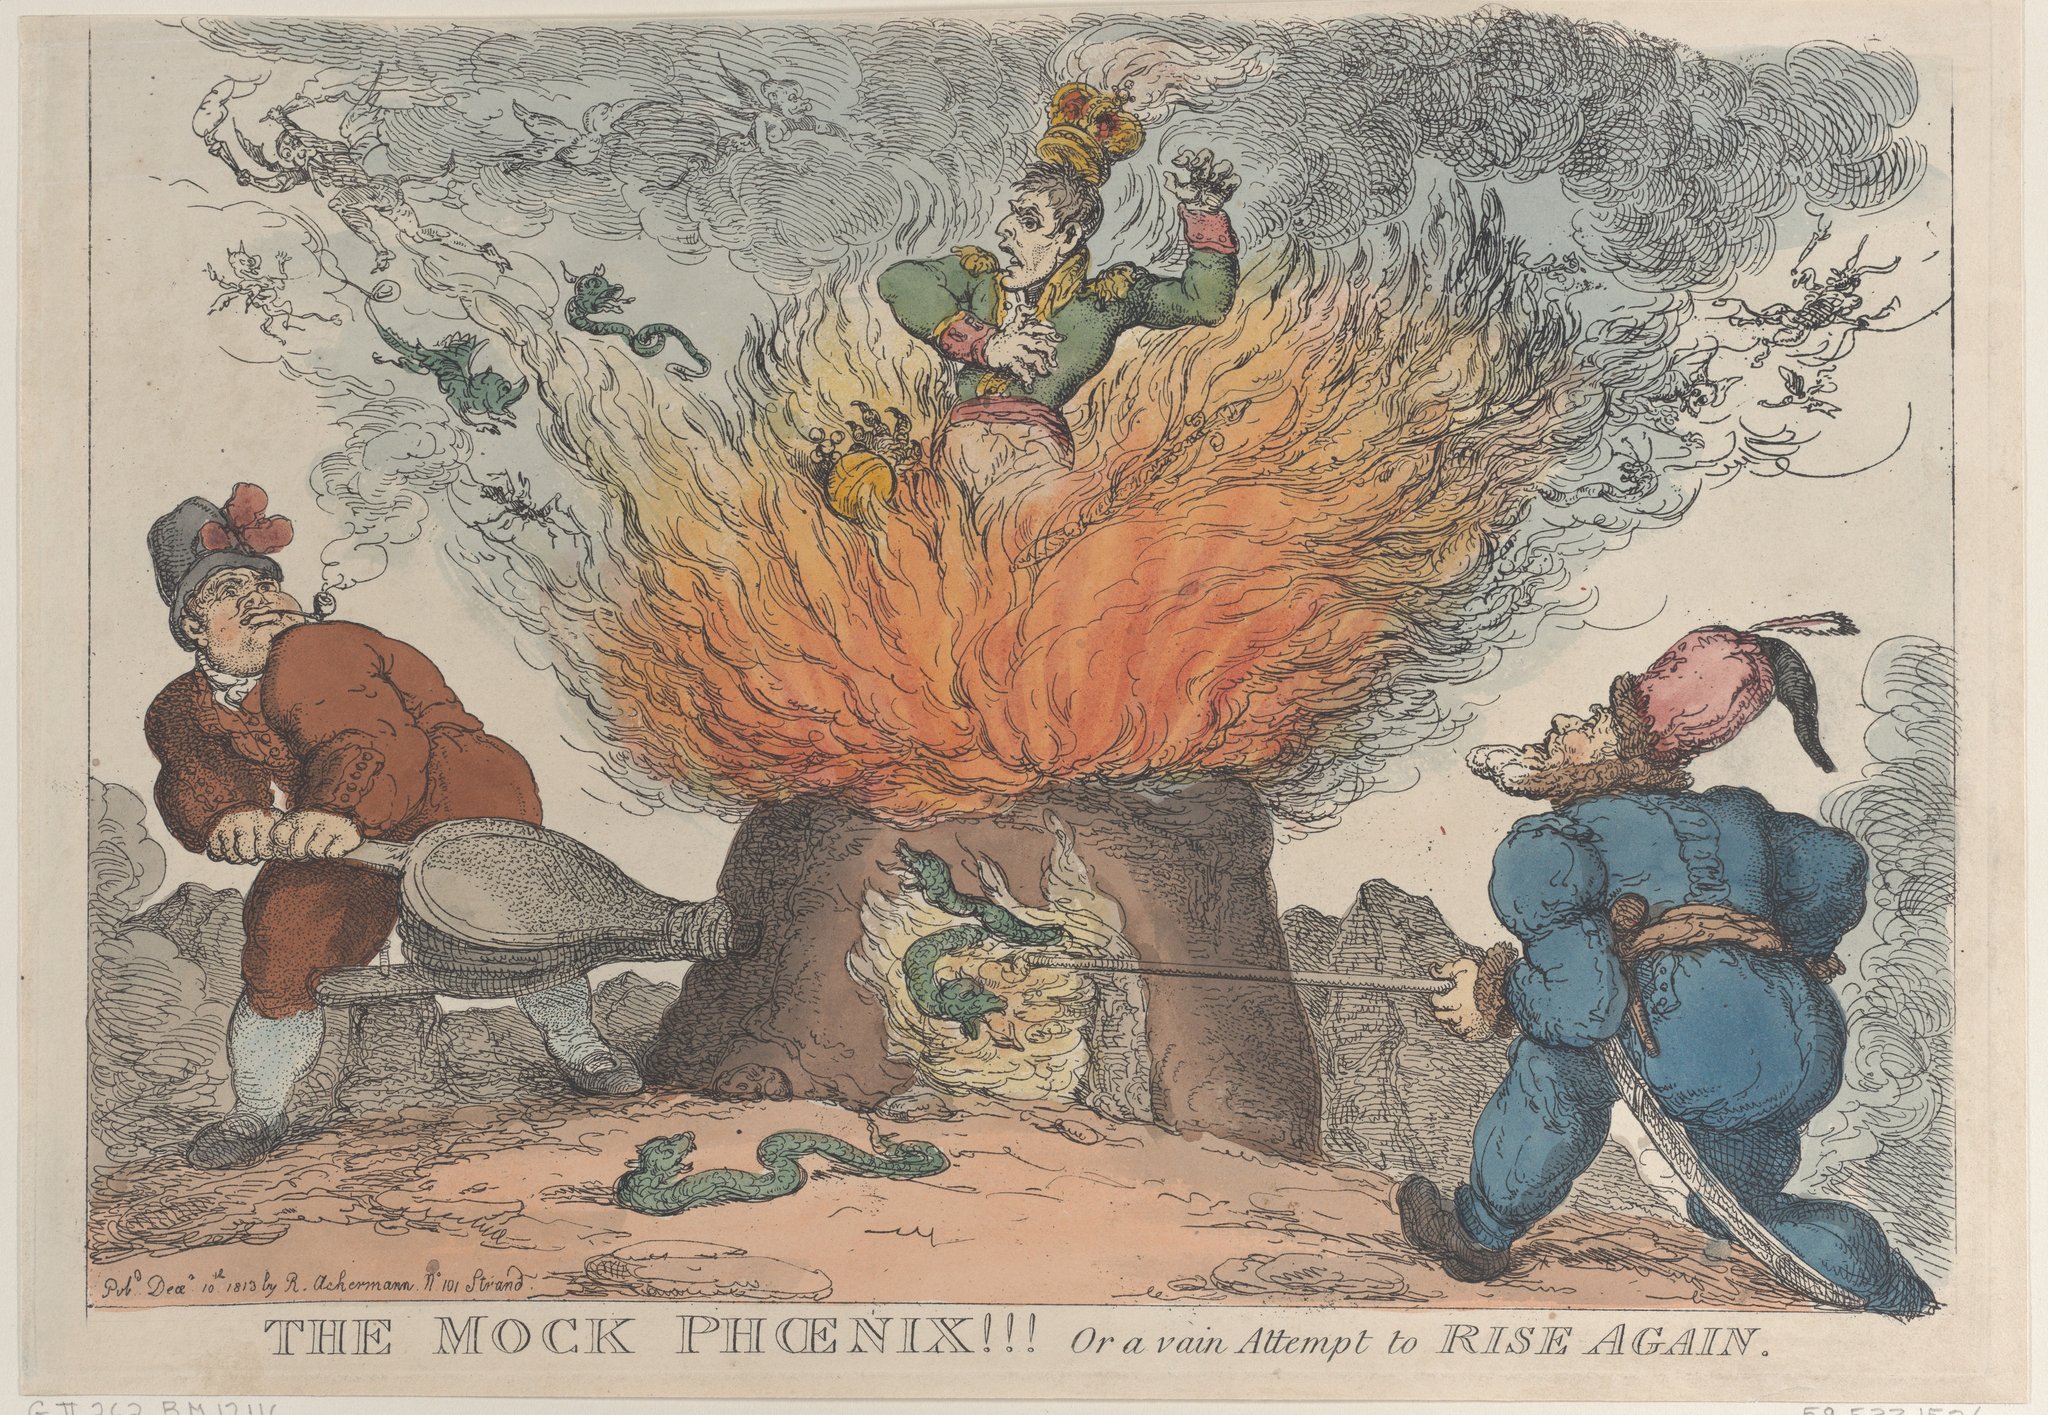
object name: print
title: The Mock Phoenix!!! Or a Vain Attempt to Rise Again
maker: thomas rowlandson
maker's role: artist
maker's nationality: british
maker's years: 1757-1827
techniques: etching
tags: satire,napoleon i,men,snakes,fire,politics